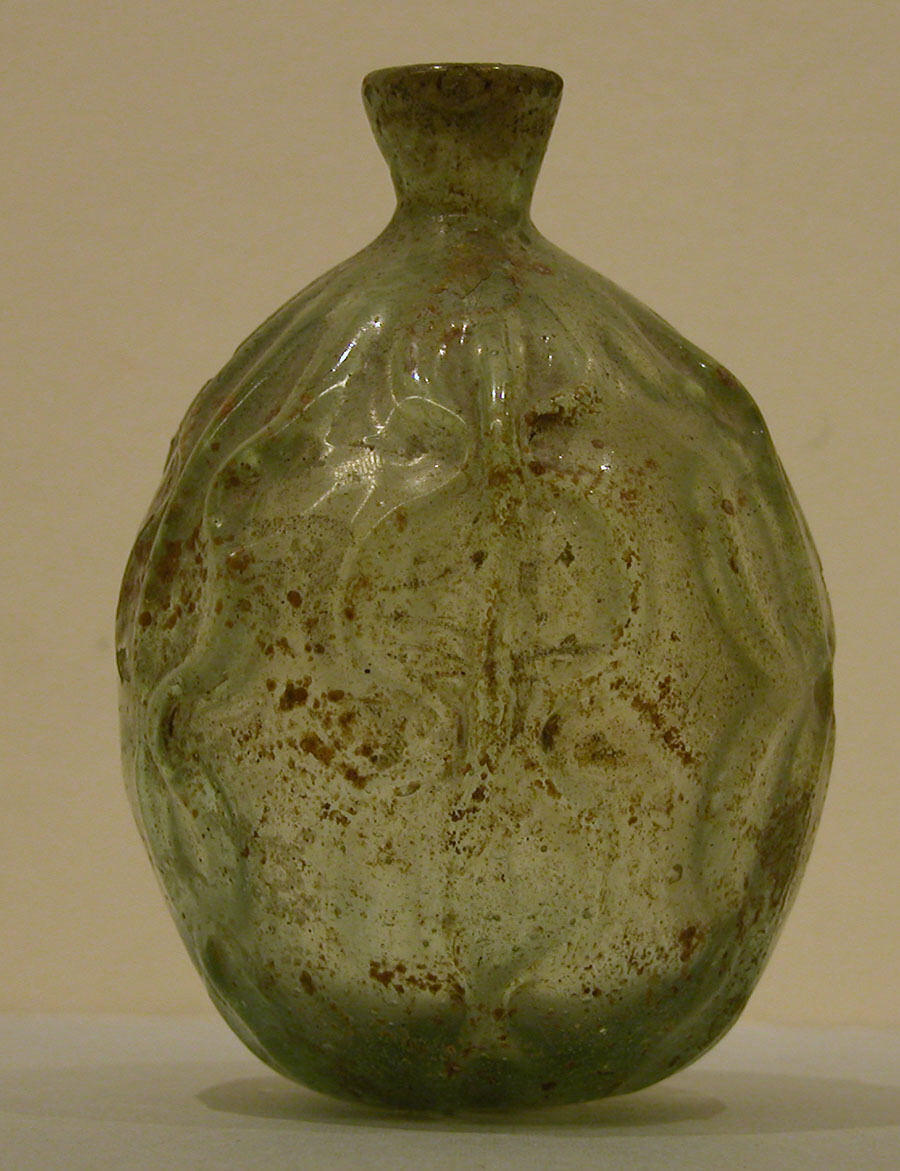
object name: bottle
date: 701-900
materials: glass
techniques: glassblowing, tooling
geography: iran